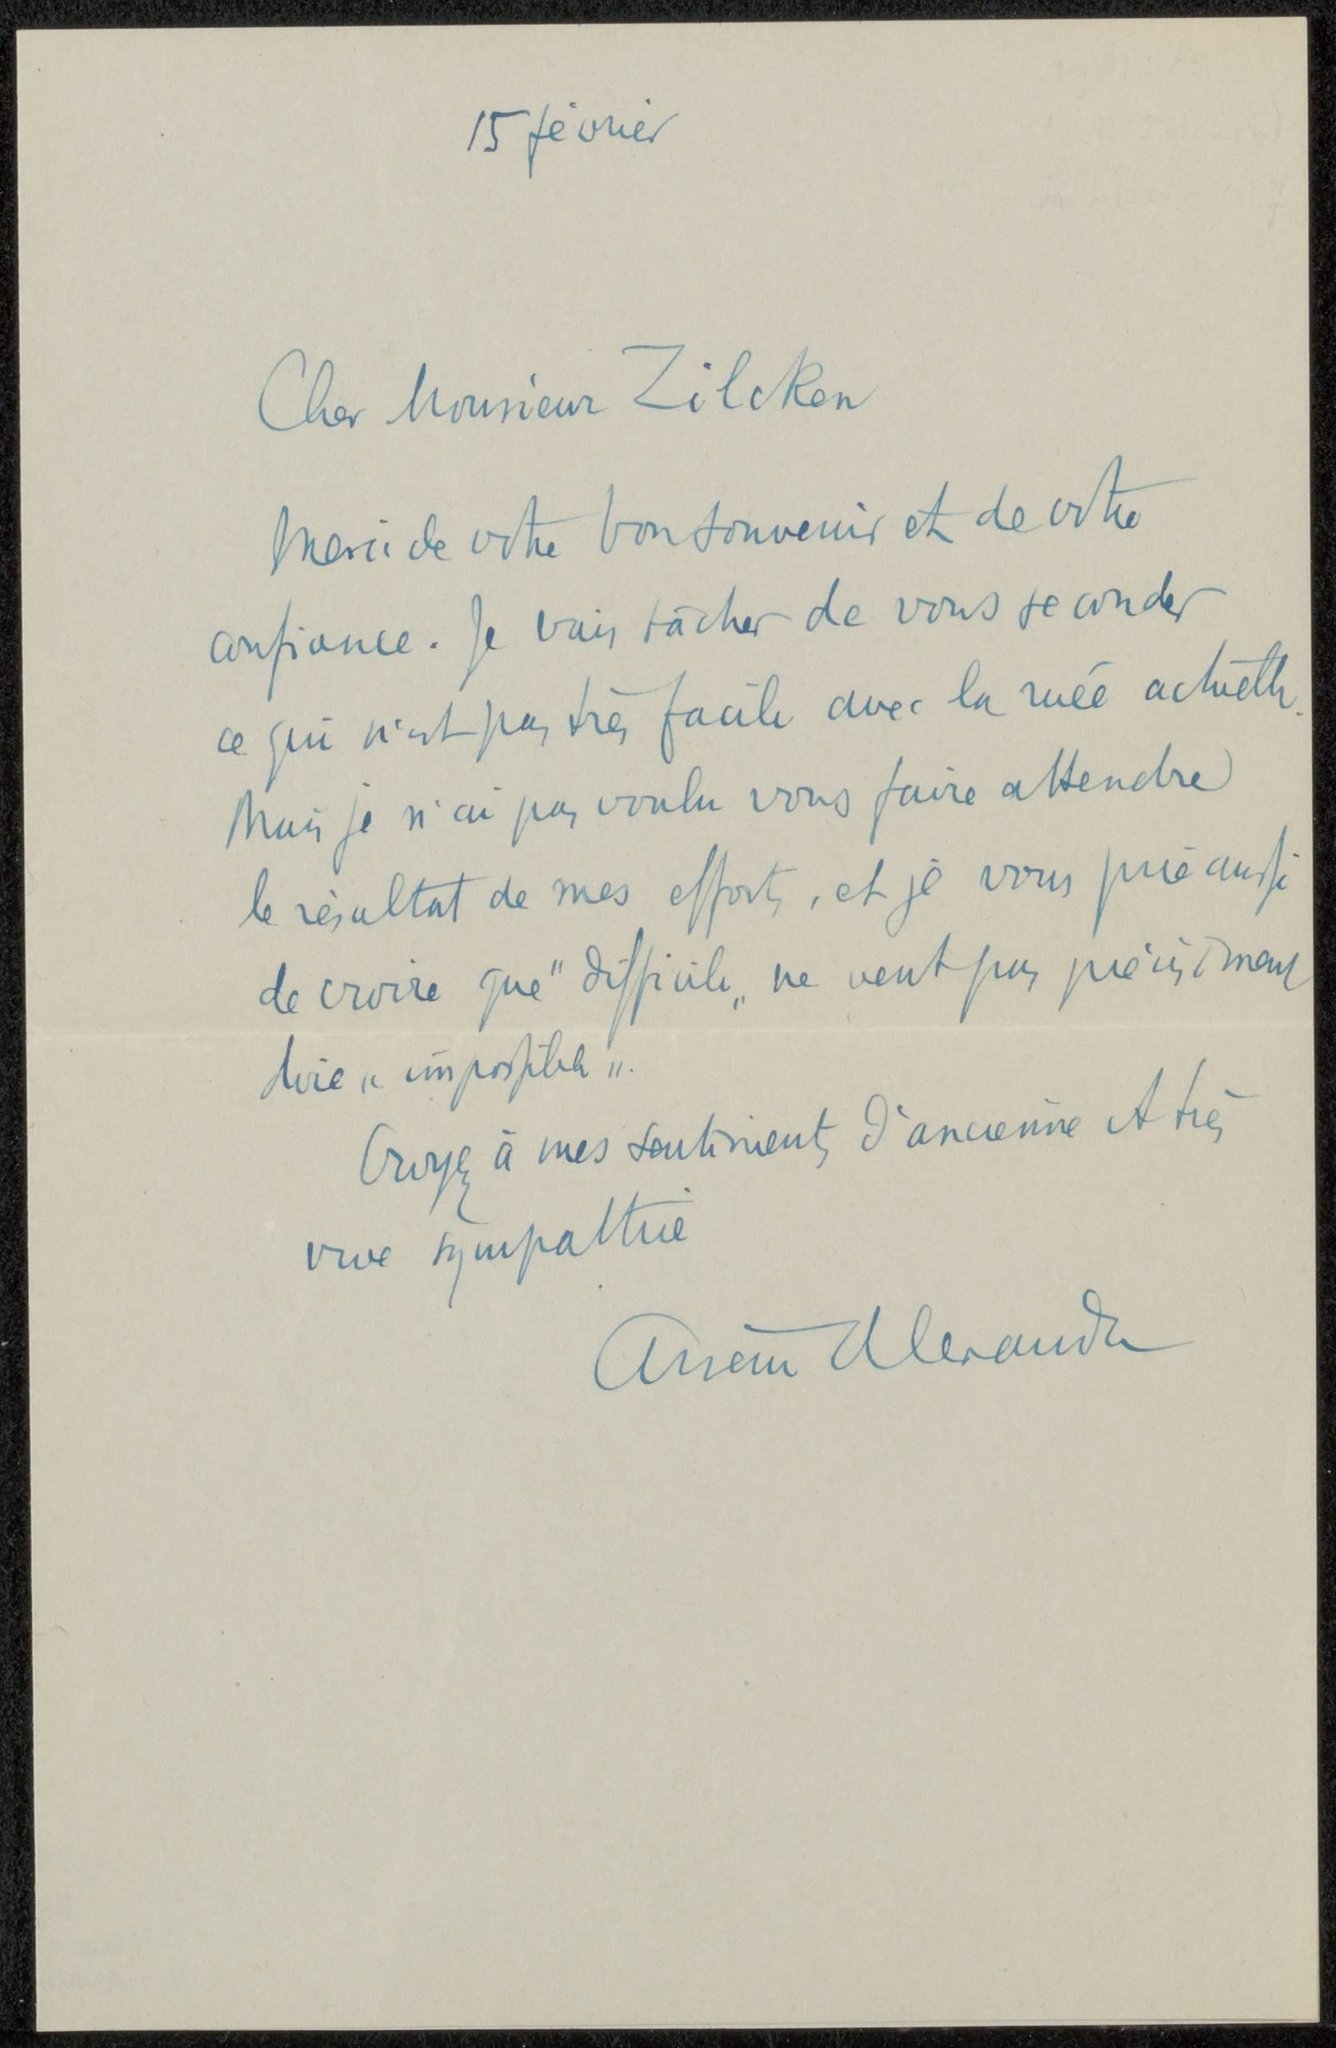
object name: letter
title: Brief aan Philip Zilcken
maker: arsène alexandre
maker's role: auteur, verzamelaar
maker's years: 1859-1937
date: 1925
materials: ink, paper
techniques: pen, writing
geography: paris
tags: the hague, painter, draughtsman, philip zilcken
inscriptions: collector's mark: ‘RPK’